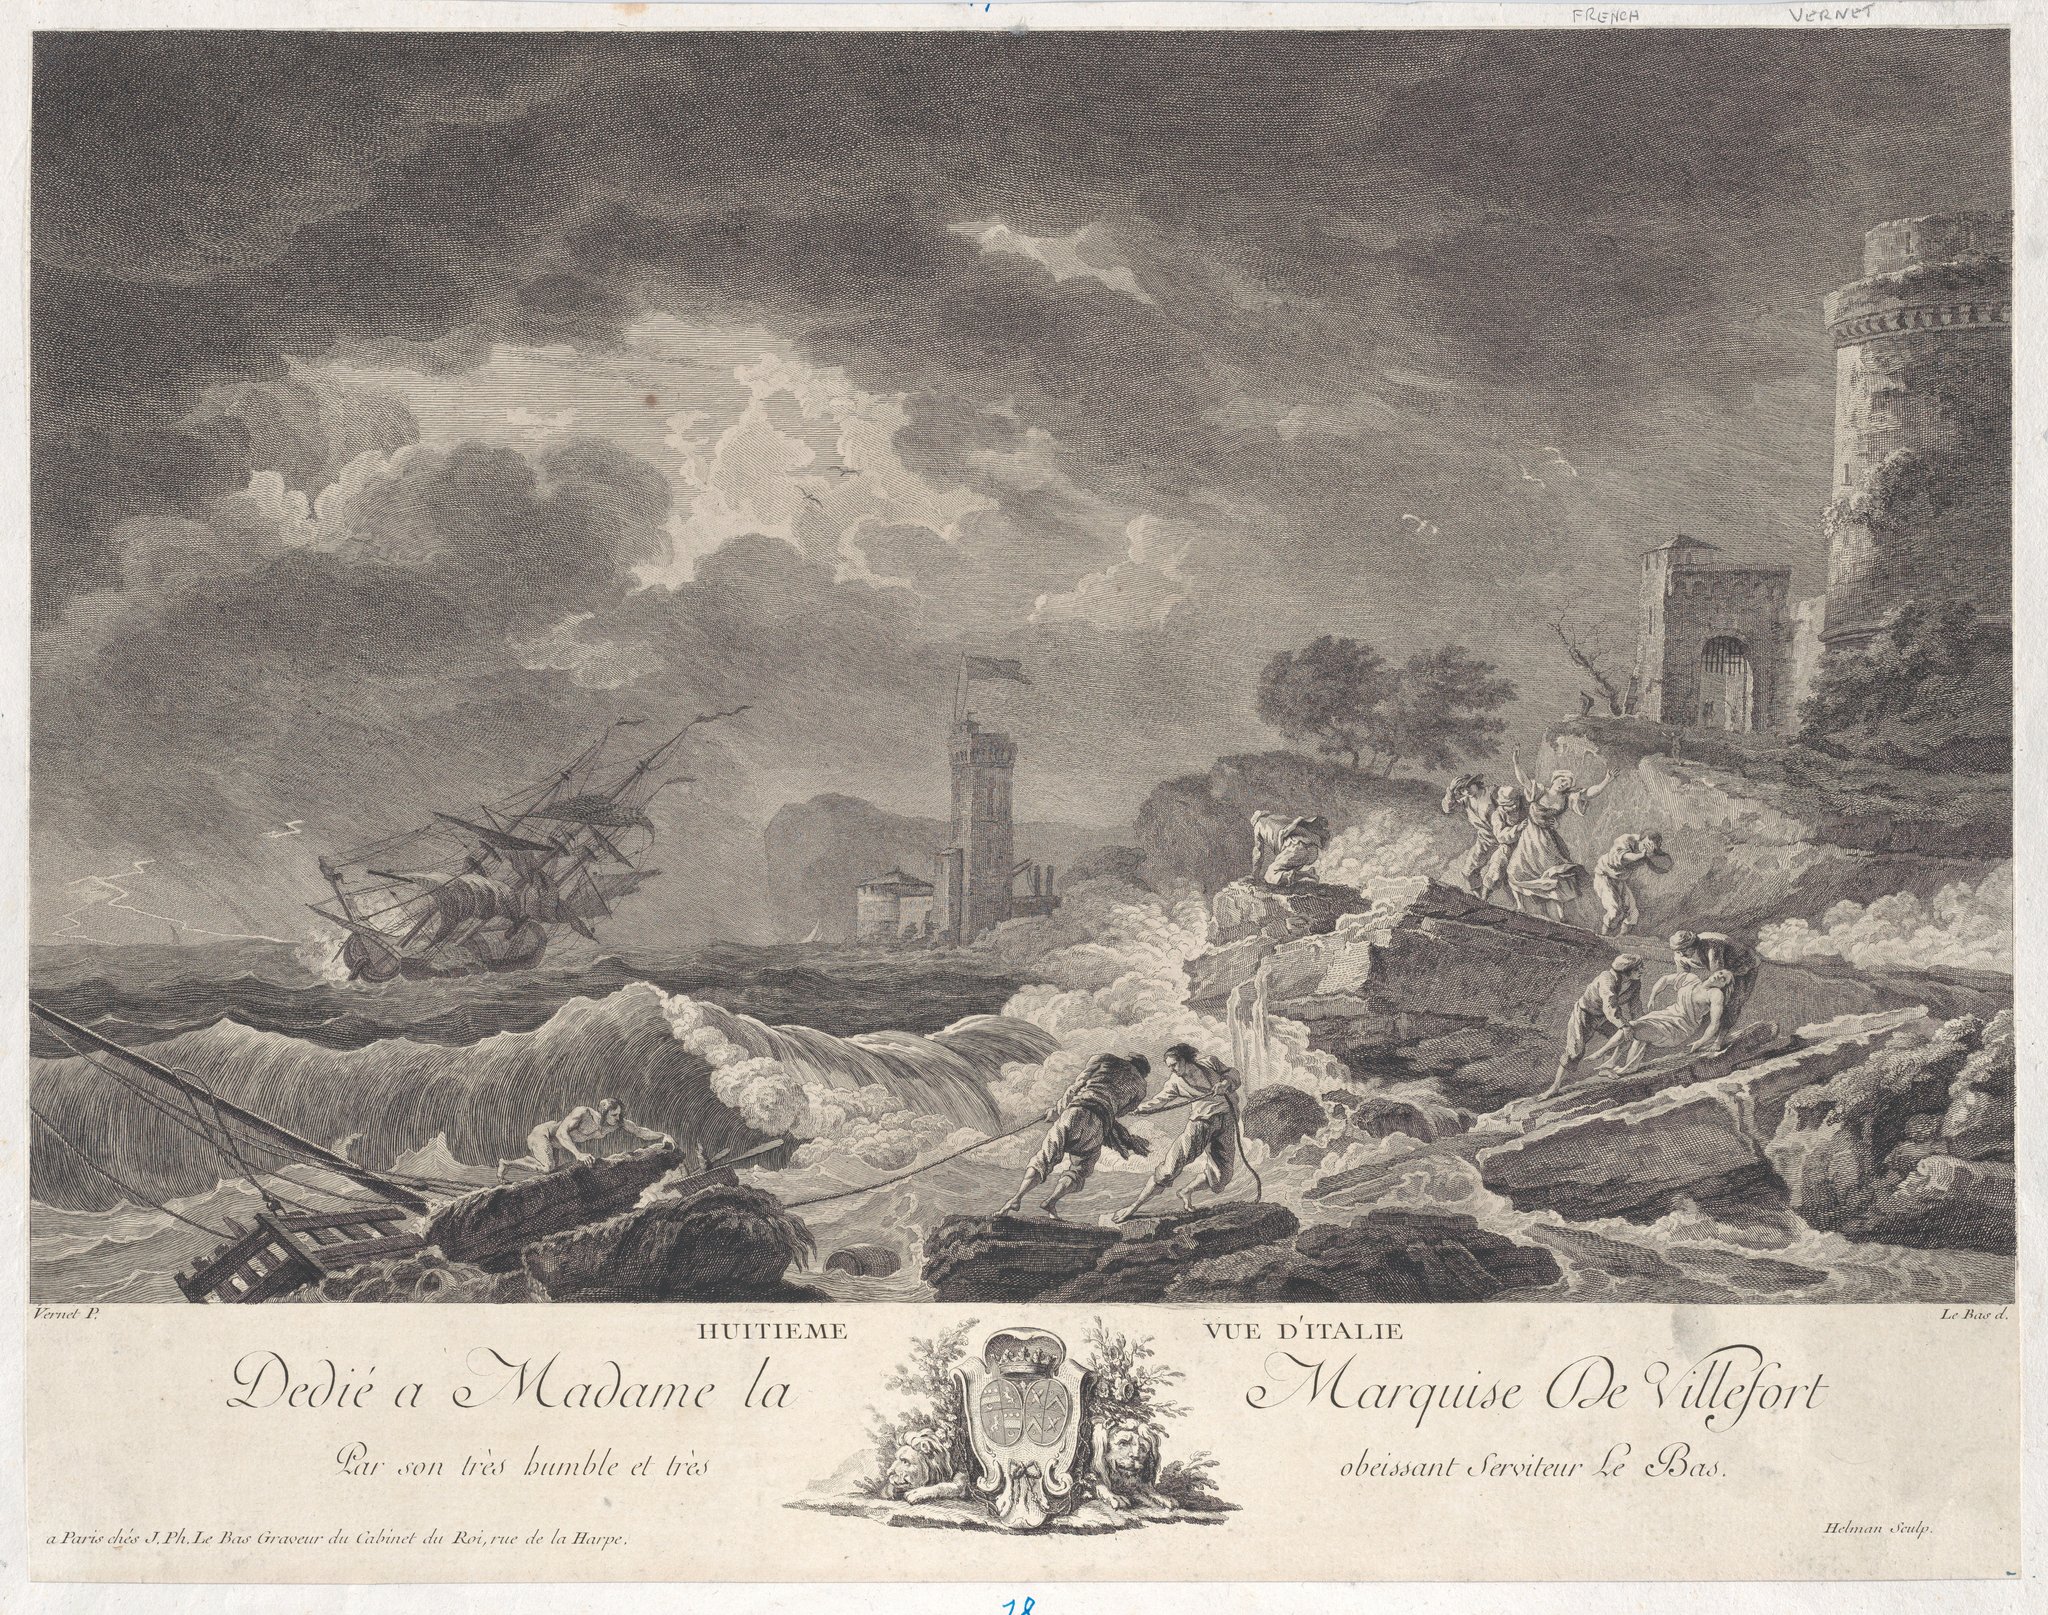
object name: print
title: Eighth View of Italy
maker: joseph vernet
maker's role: artist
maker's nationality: french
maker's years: 1714-1789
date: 1770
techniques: engraving